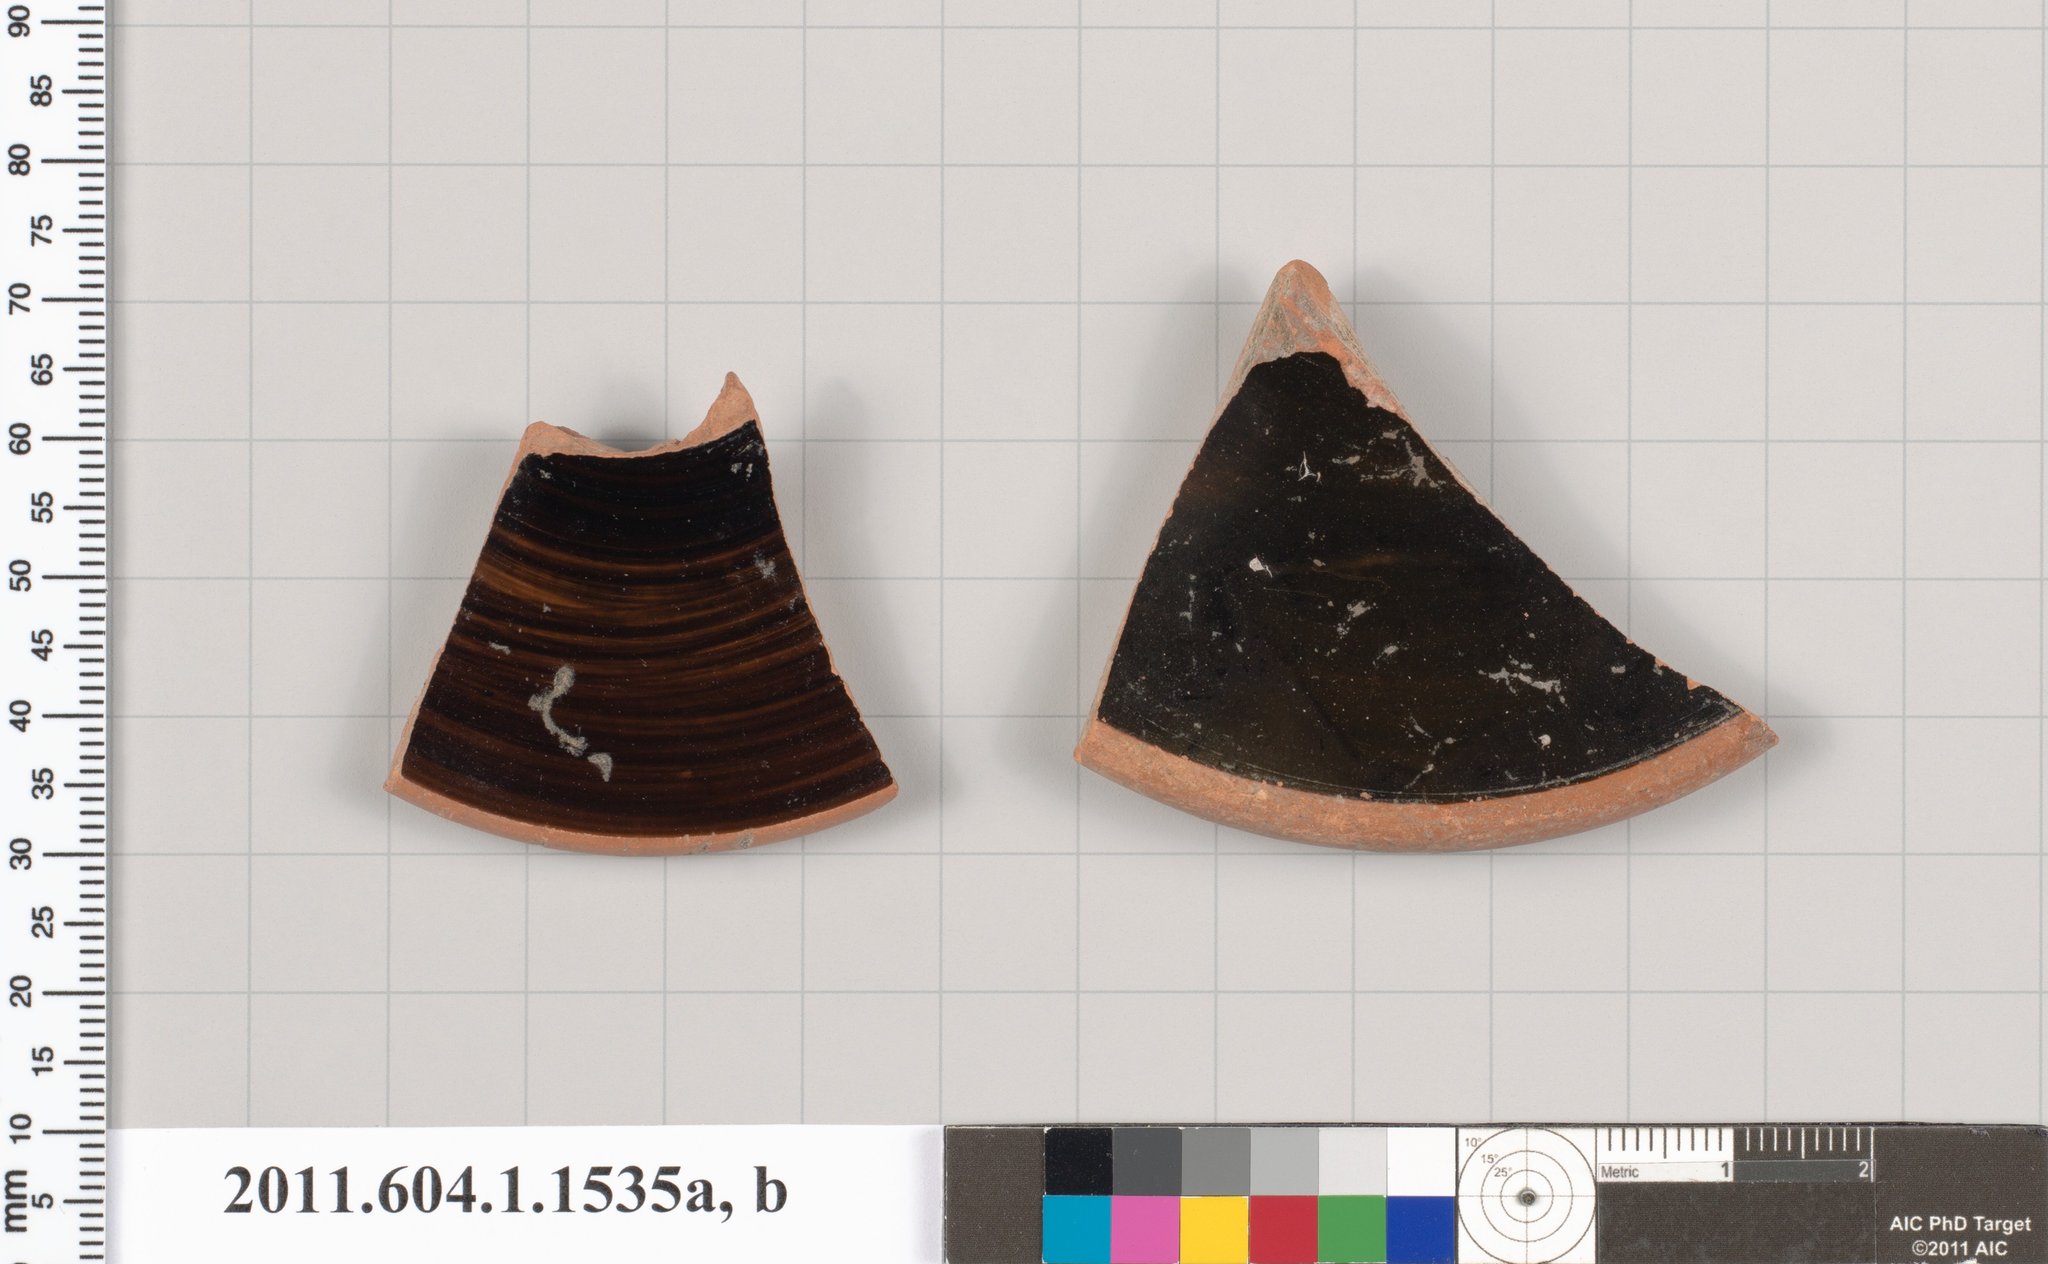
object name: kylix fragment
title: Terracotta fragments of kylikes (drinking cups)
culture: greek, attic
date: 500-401 BCE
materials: terracotta